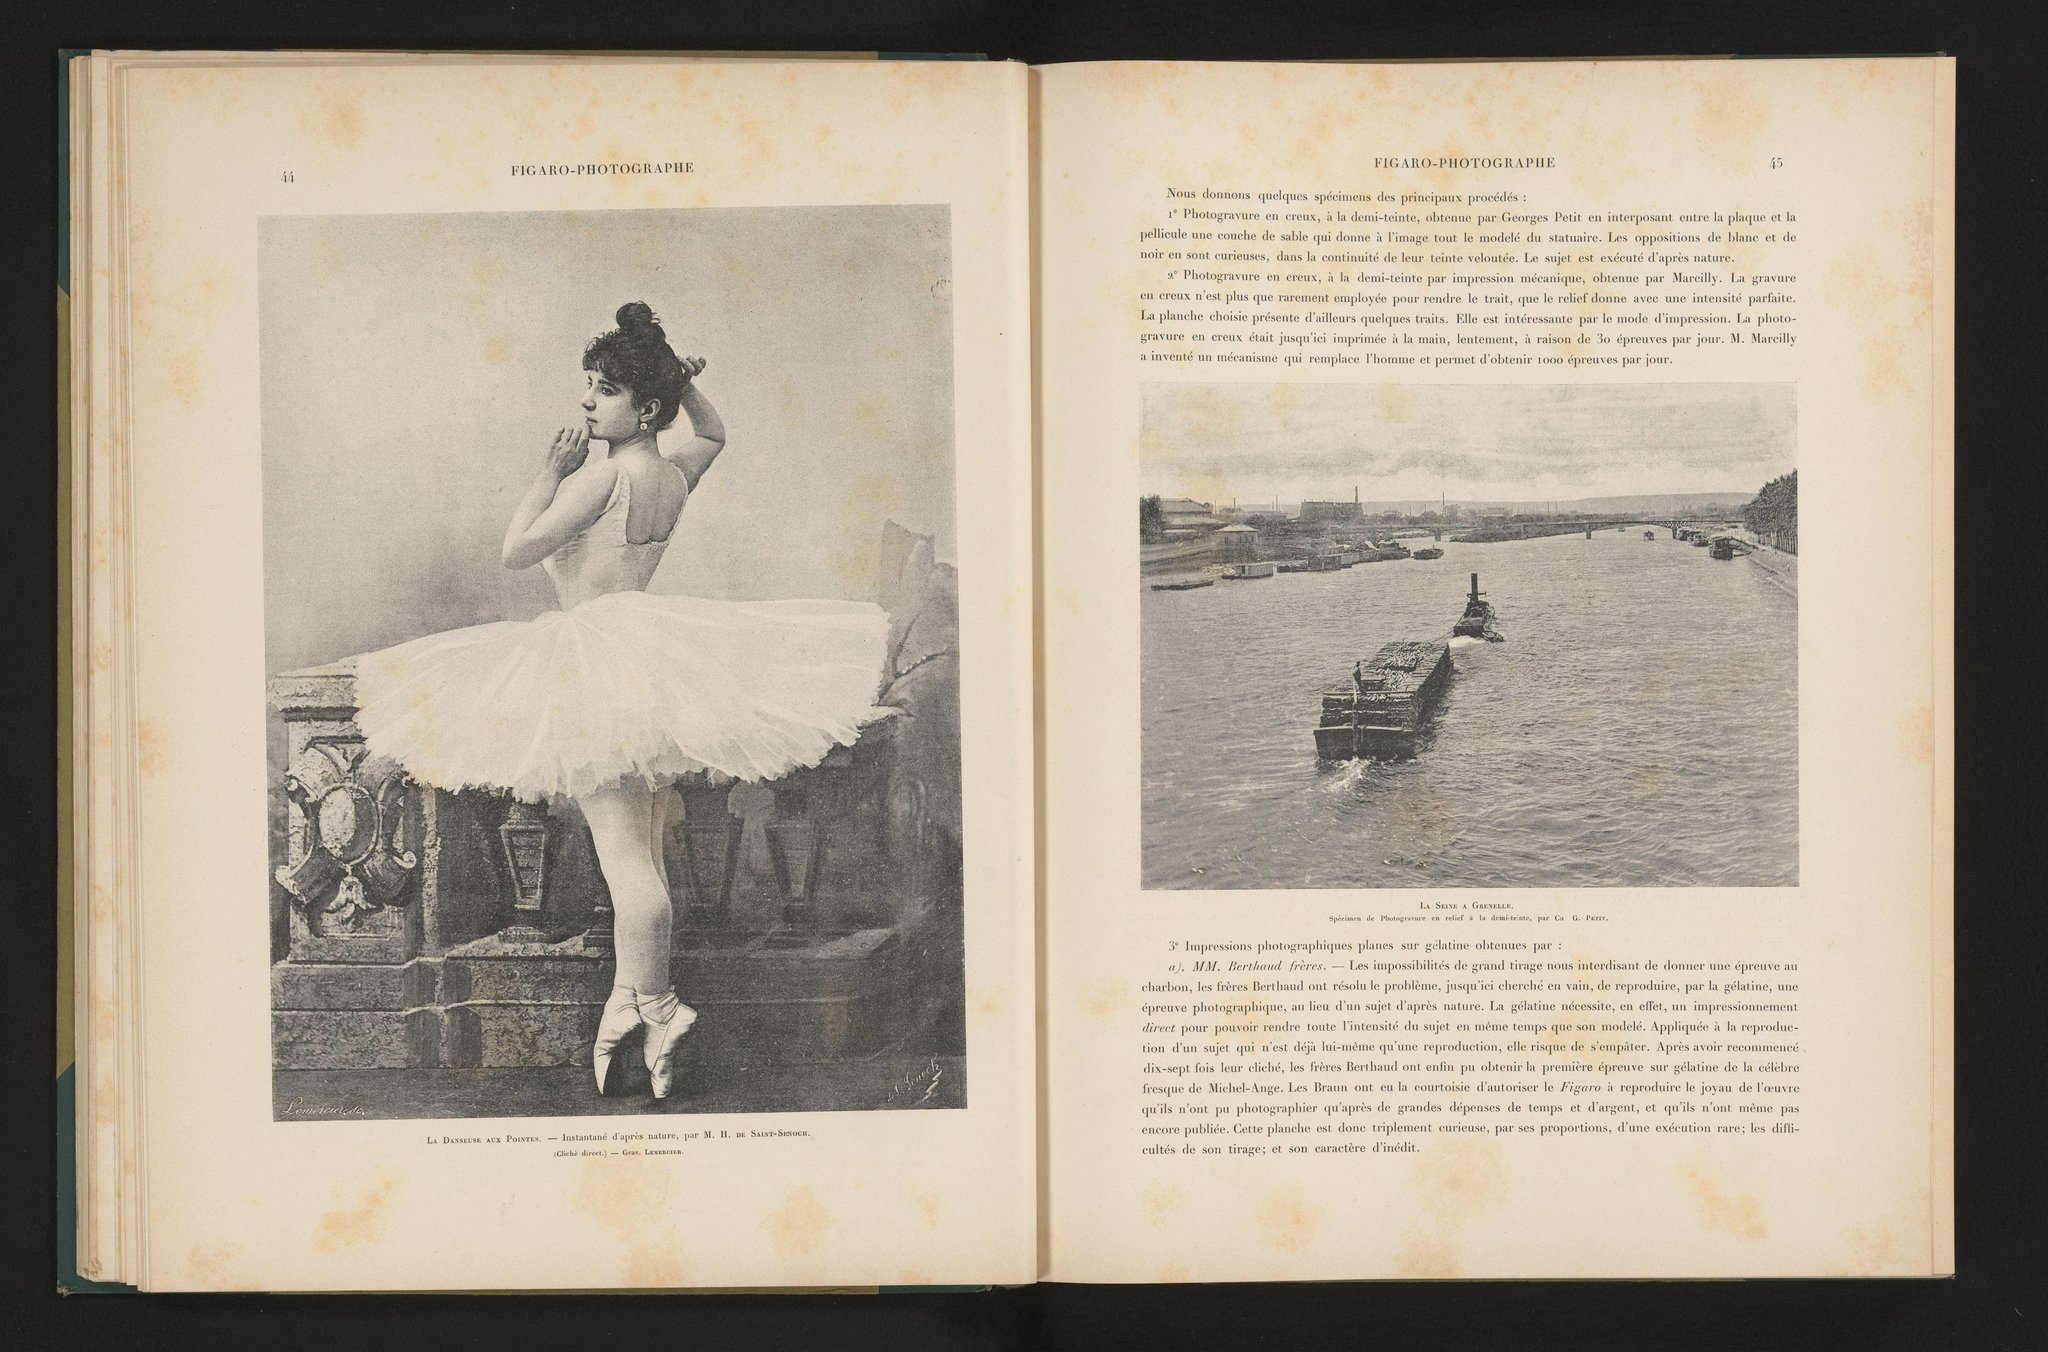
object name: photomechanical print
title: Balletdanseres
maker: edgar haincque de saint senoch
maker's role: fotograaf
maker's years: 1839-1904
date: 1887-1892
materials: paper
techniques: collo-autotype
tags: historical persons - bb - woman, female dancer